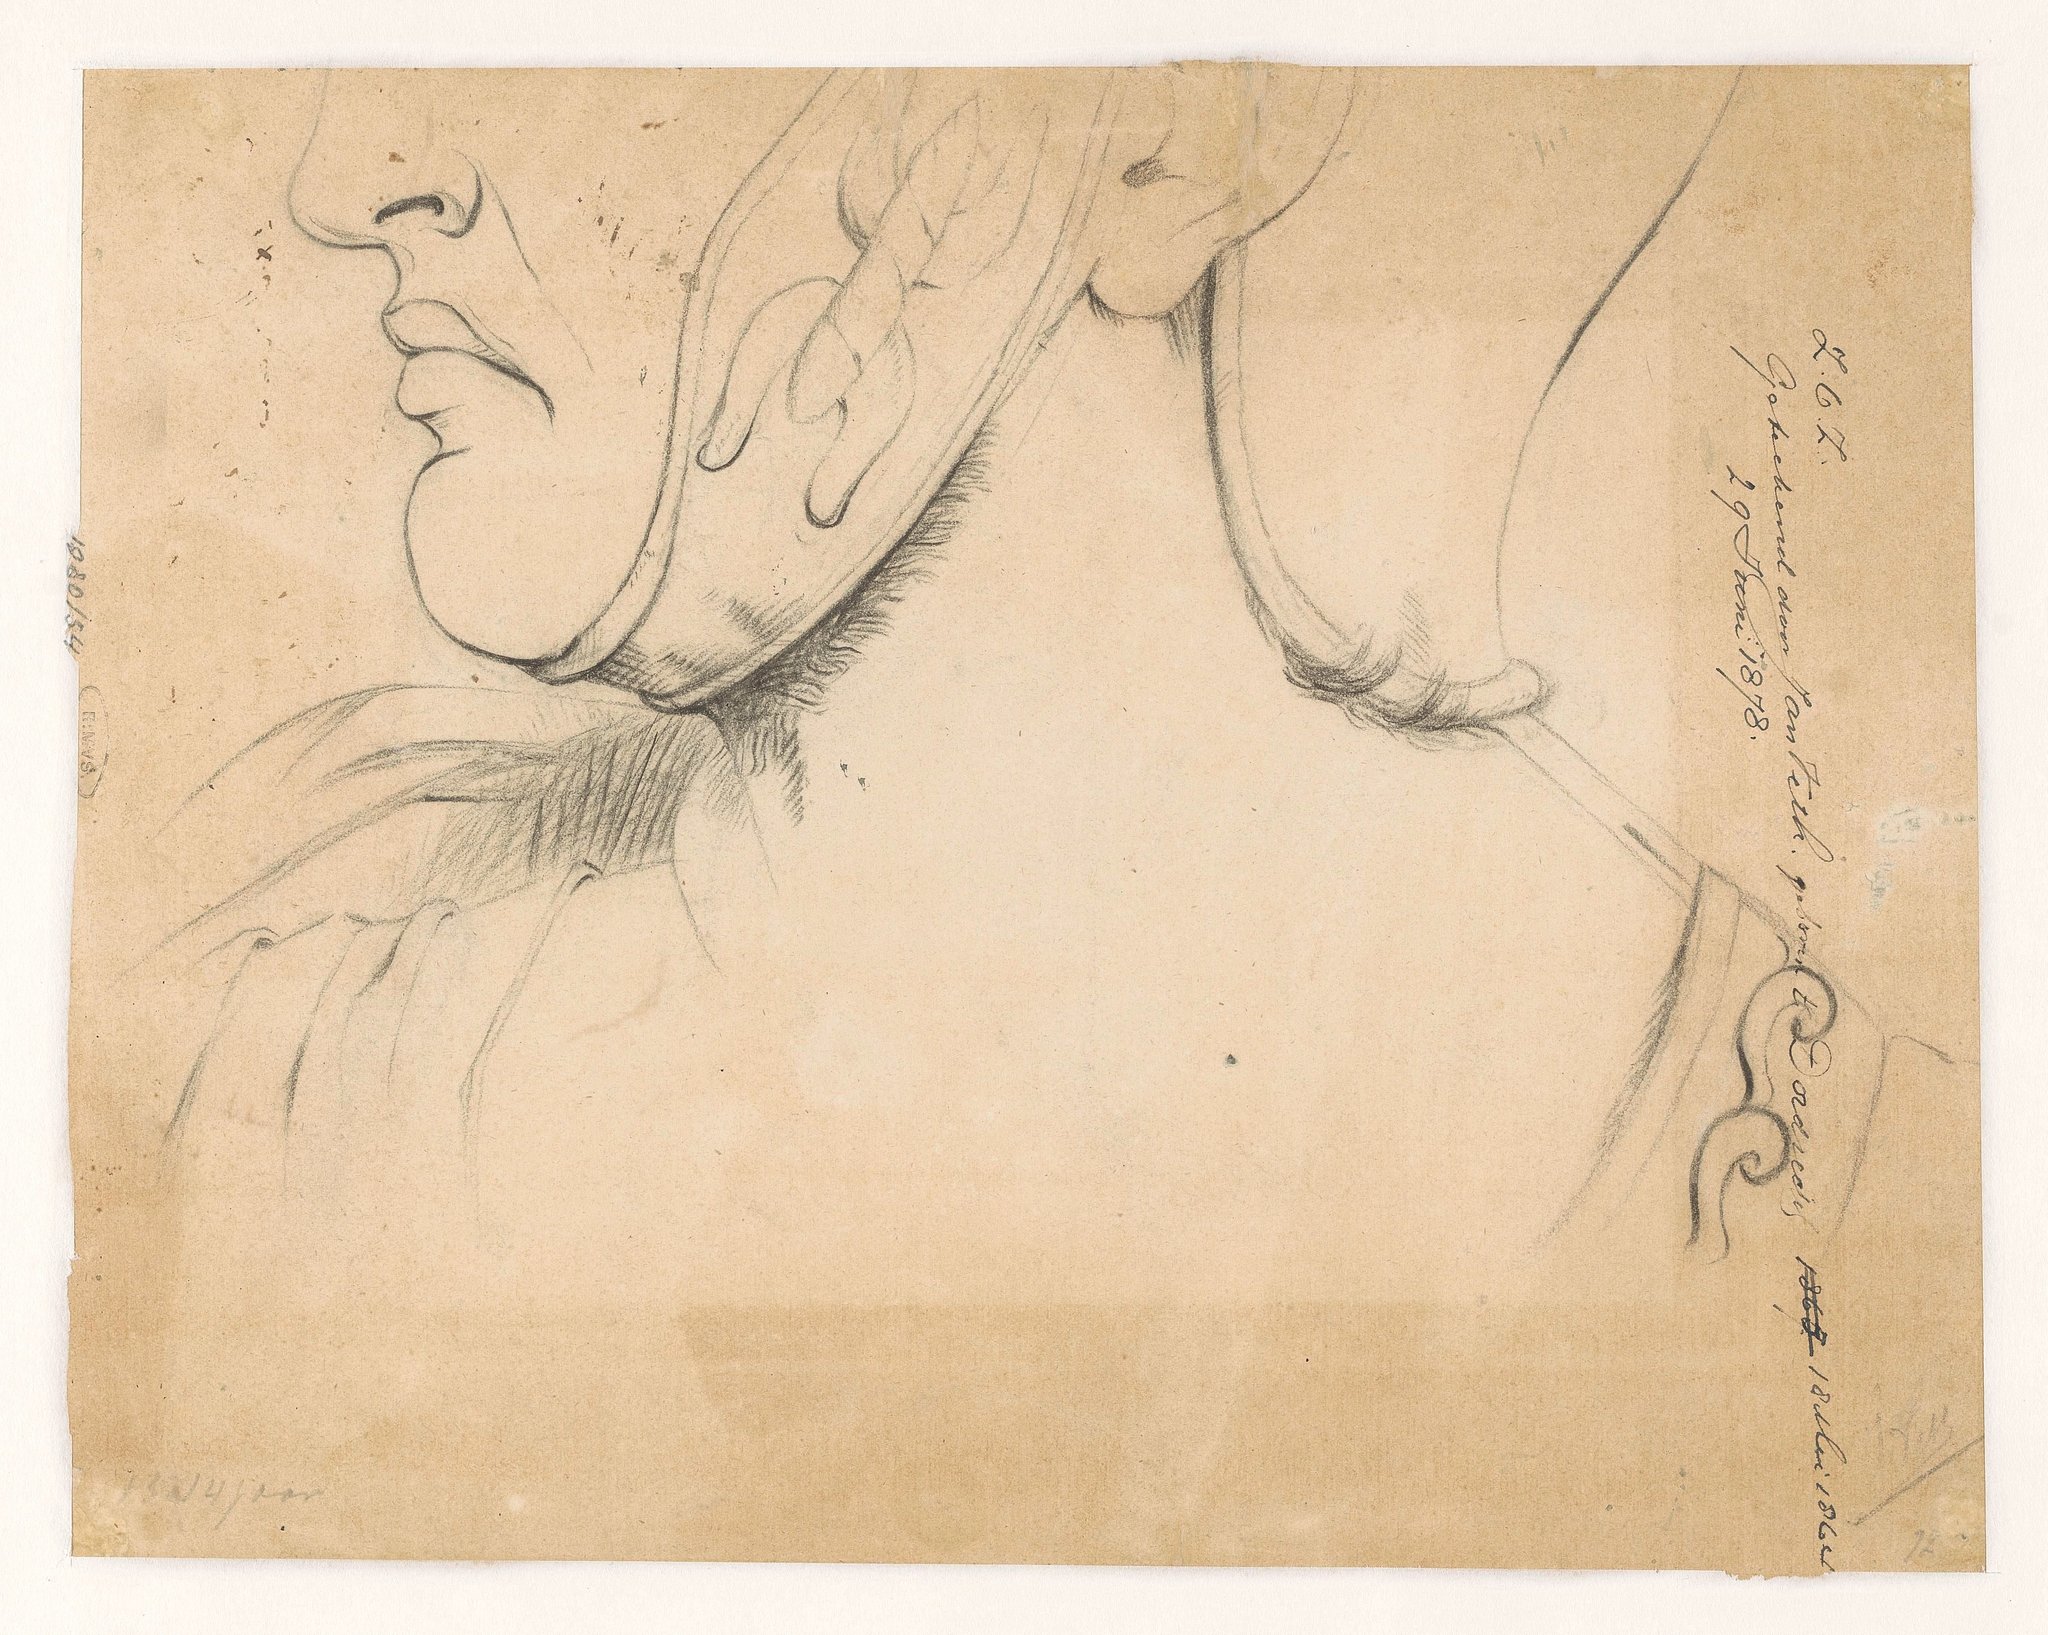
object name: drawing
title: Fragment van een grotere tekening van een Romeinse soldaat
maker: jan veth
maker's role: designer, draughtsman, painter, print maker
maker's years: 1864-1925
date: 1874-1925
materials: chalk, paper